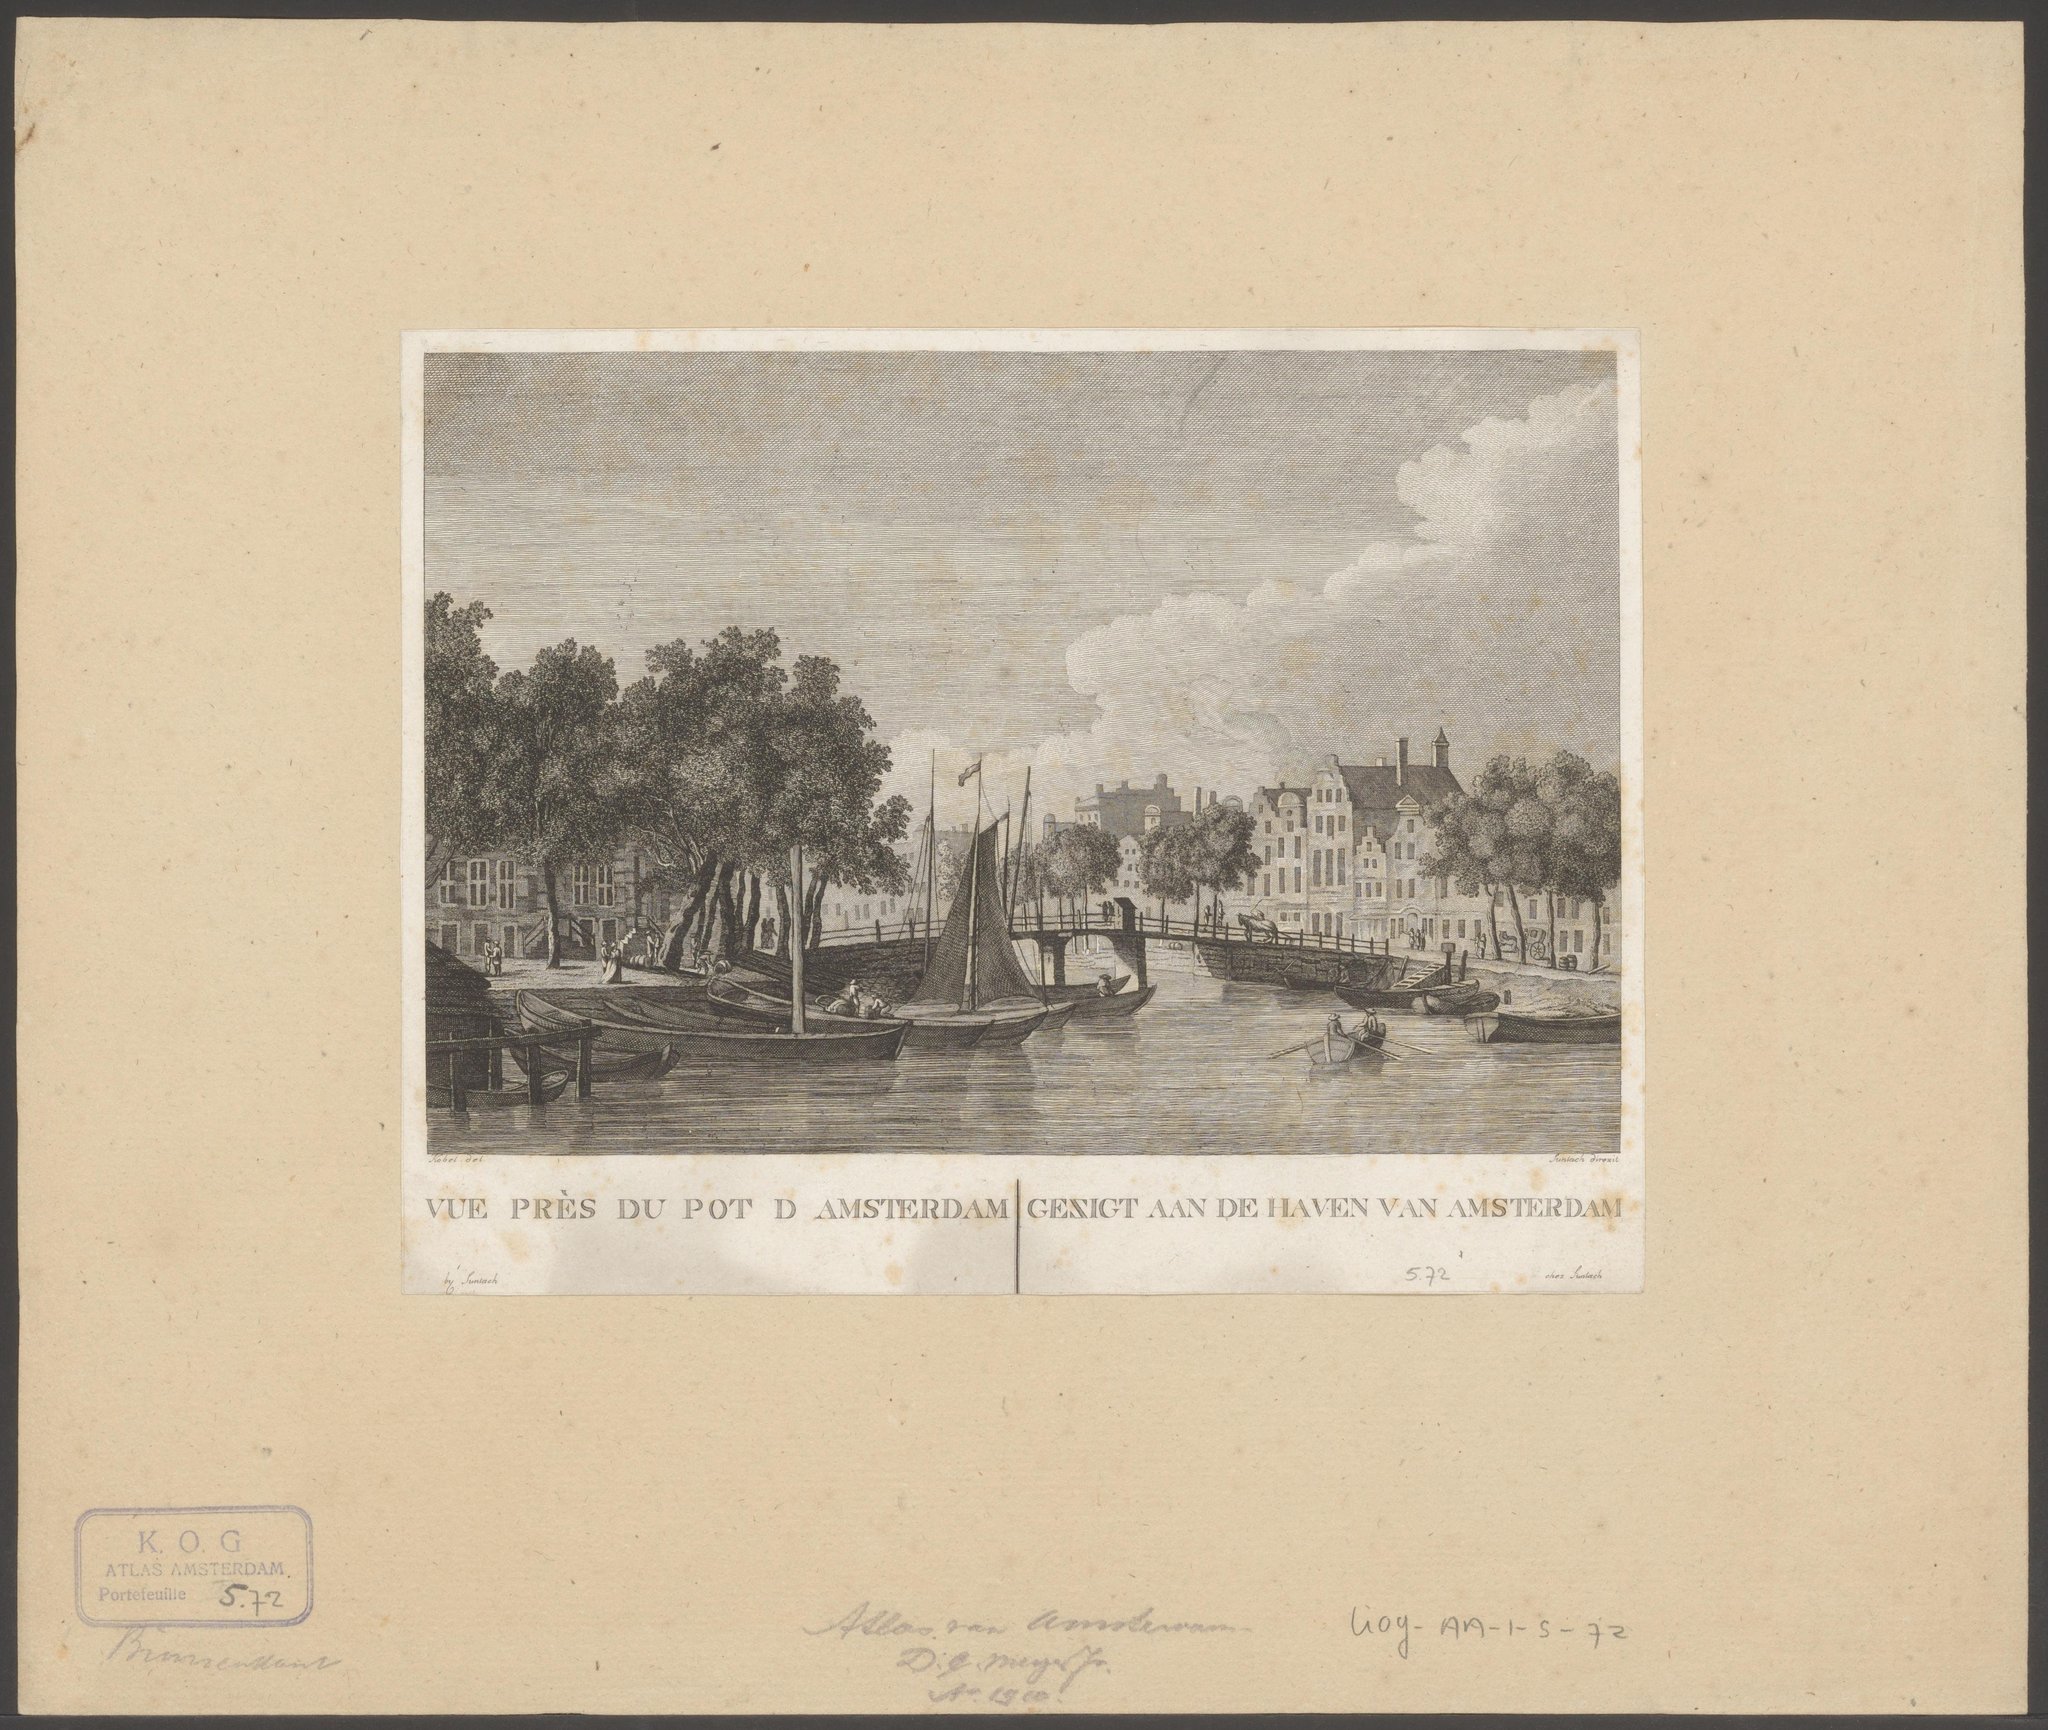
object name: print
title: Gezigt aan de Haven van Amsterdam / Vue Pres du Pot d Amsterdam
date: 1700-1799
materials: paper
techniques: etching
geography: amsterdam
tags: harbour, sailing-ship, sailing-boat, city-view in general; 'veduta'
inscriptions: inscription: ‘Atlas van Amsterdam / D:C Meyer Jr / Ao. 1910’, collector's mark: ‘5.72’ Lugt 1641b, name: ‘Suntach (?)’, name: ‘Kobel’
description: Onderwerpsrubriek binnen de Atlas Amsterdam: Begijnensloot (Gedempte), Bagijnhofsteeg, Beulingsloot, Bickersgracht en –plein, Bickersstraat (Groote), Bilderdijkskade en -straat, Binnenkant, Blauwburgwal, Boomdwarsstraat, Brouwersgracht, Bleekersspad (Lange), Bleekerssloot, Bloemgracht, Boerenwetering, Boltensgrachtje, Boomssloot (Recht), Badhuisweg.